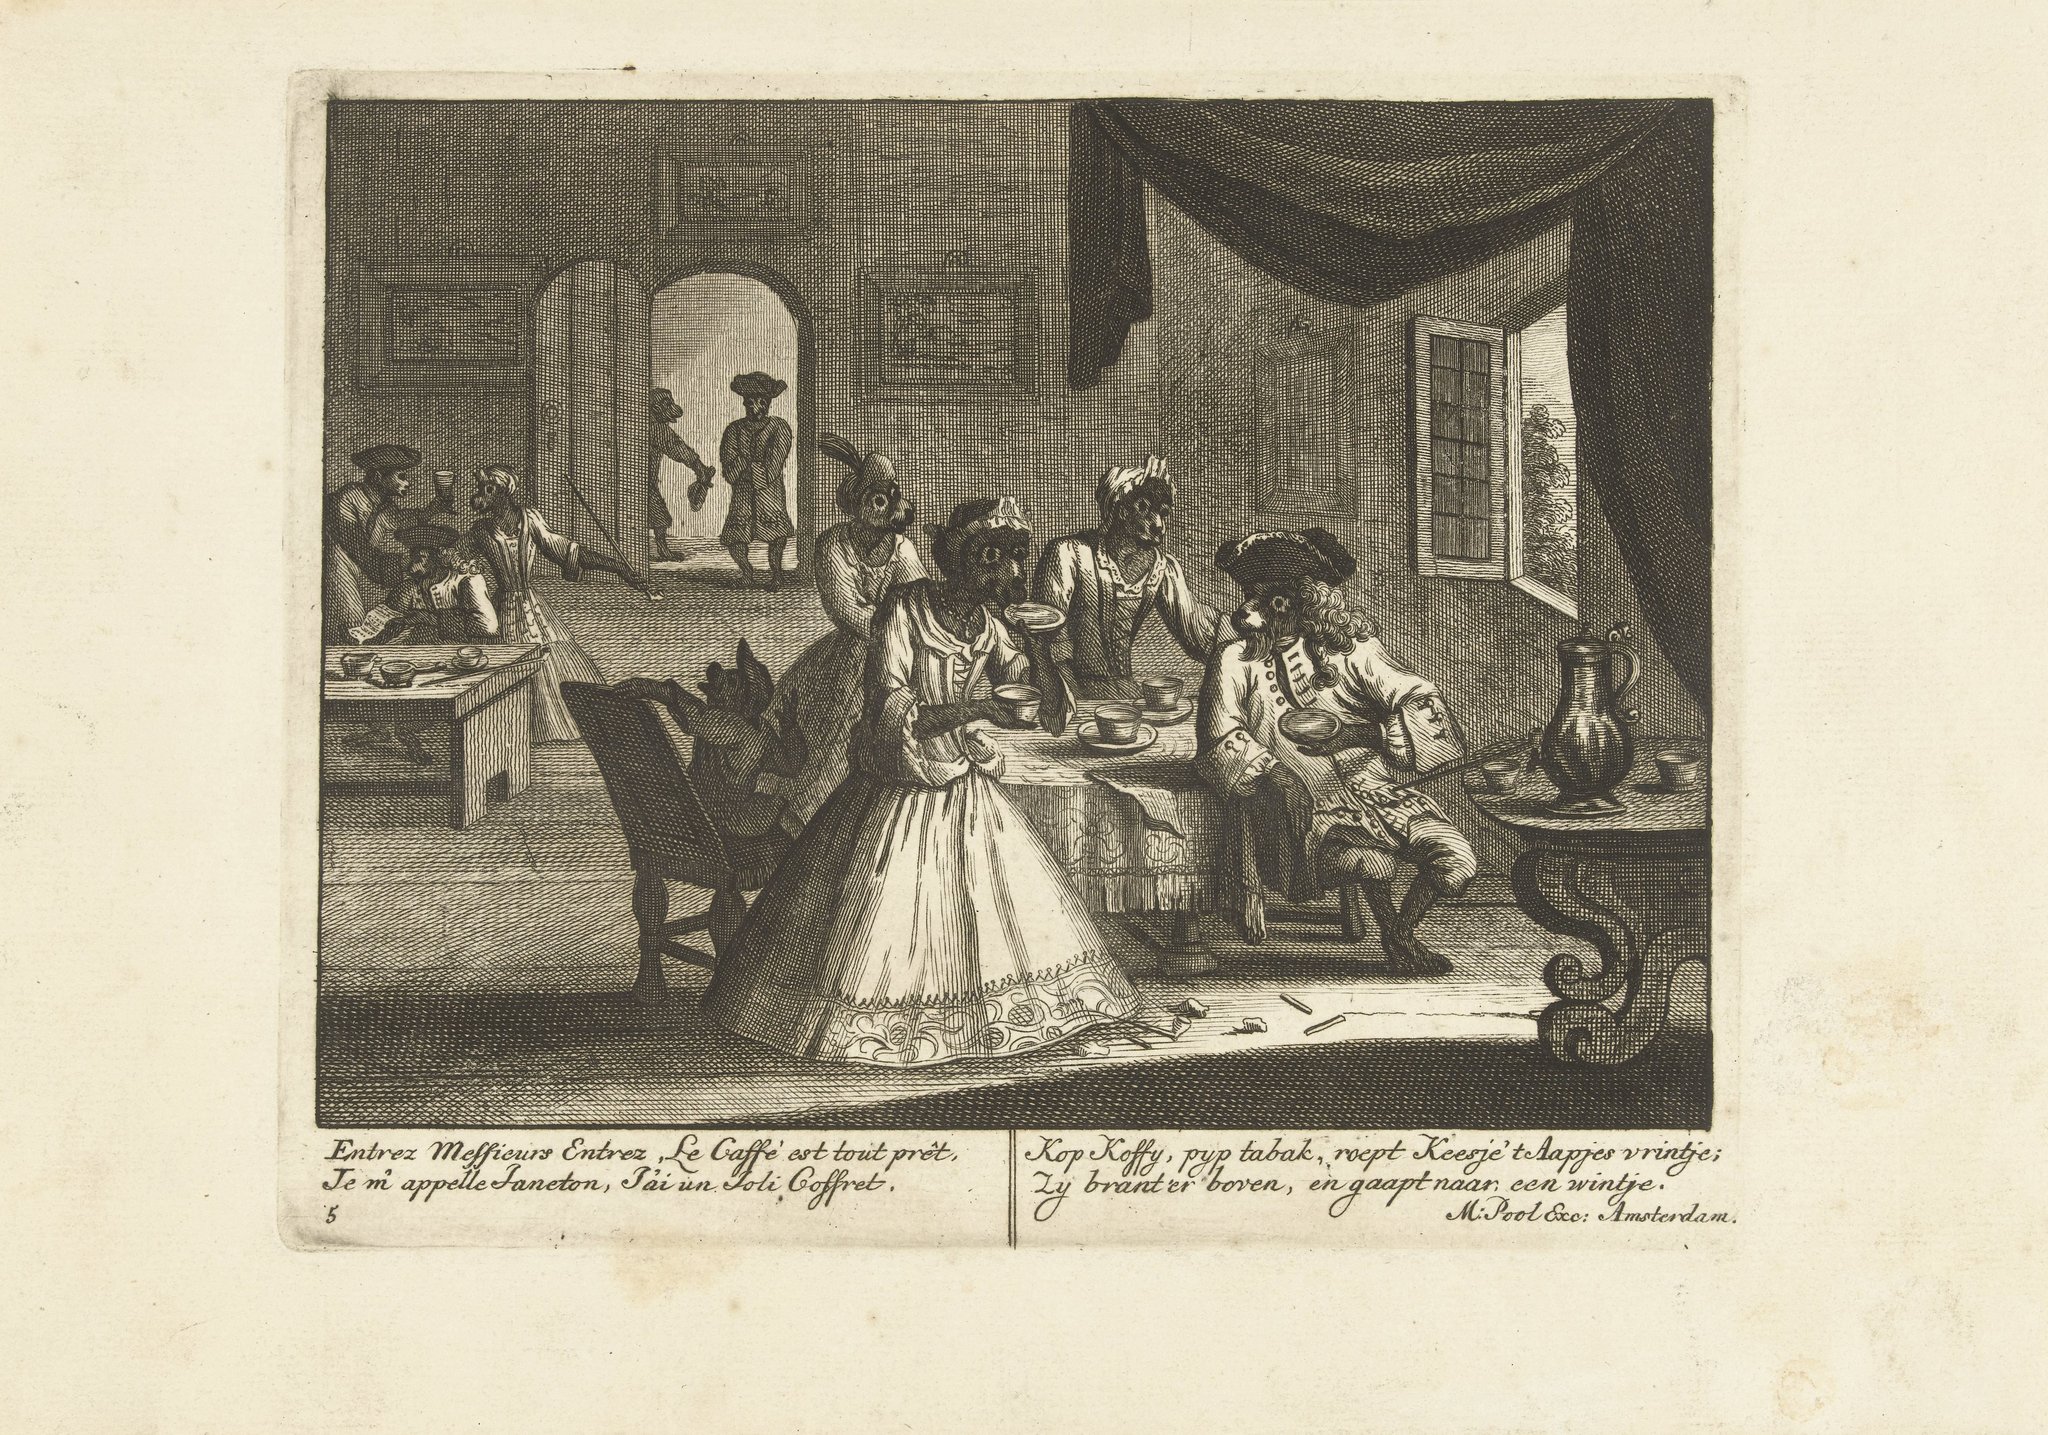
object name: print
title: Apen die koffiedrinken, ca. 1720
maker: matthijs pool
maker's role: print maker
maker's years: 1676-1740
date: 1720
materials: paper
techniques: engraving, etching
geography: amsterdam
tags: monkeys, apes, animals acting as human beings, cup of coffee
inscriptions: collector's mark: Lugt 2228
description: Interieur van een huiskamer of koffiehuis met apen die koffiedrinken. In het onderschrift versjes in het Frans en Nederlands. Prent nr. 5 in een serie van 16 prenten van ca. 1720 waarin apen als mensen figureren in allerlei huishoudelijke taferelen.